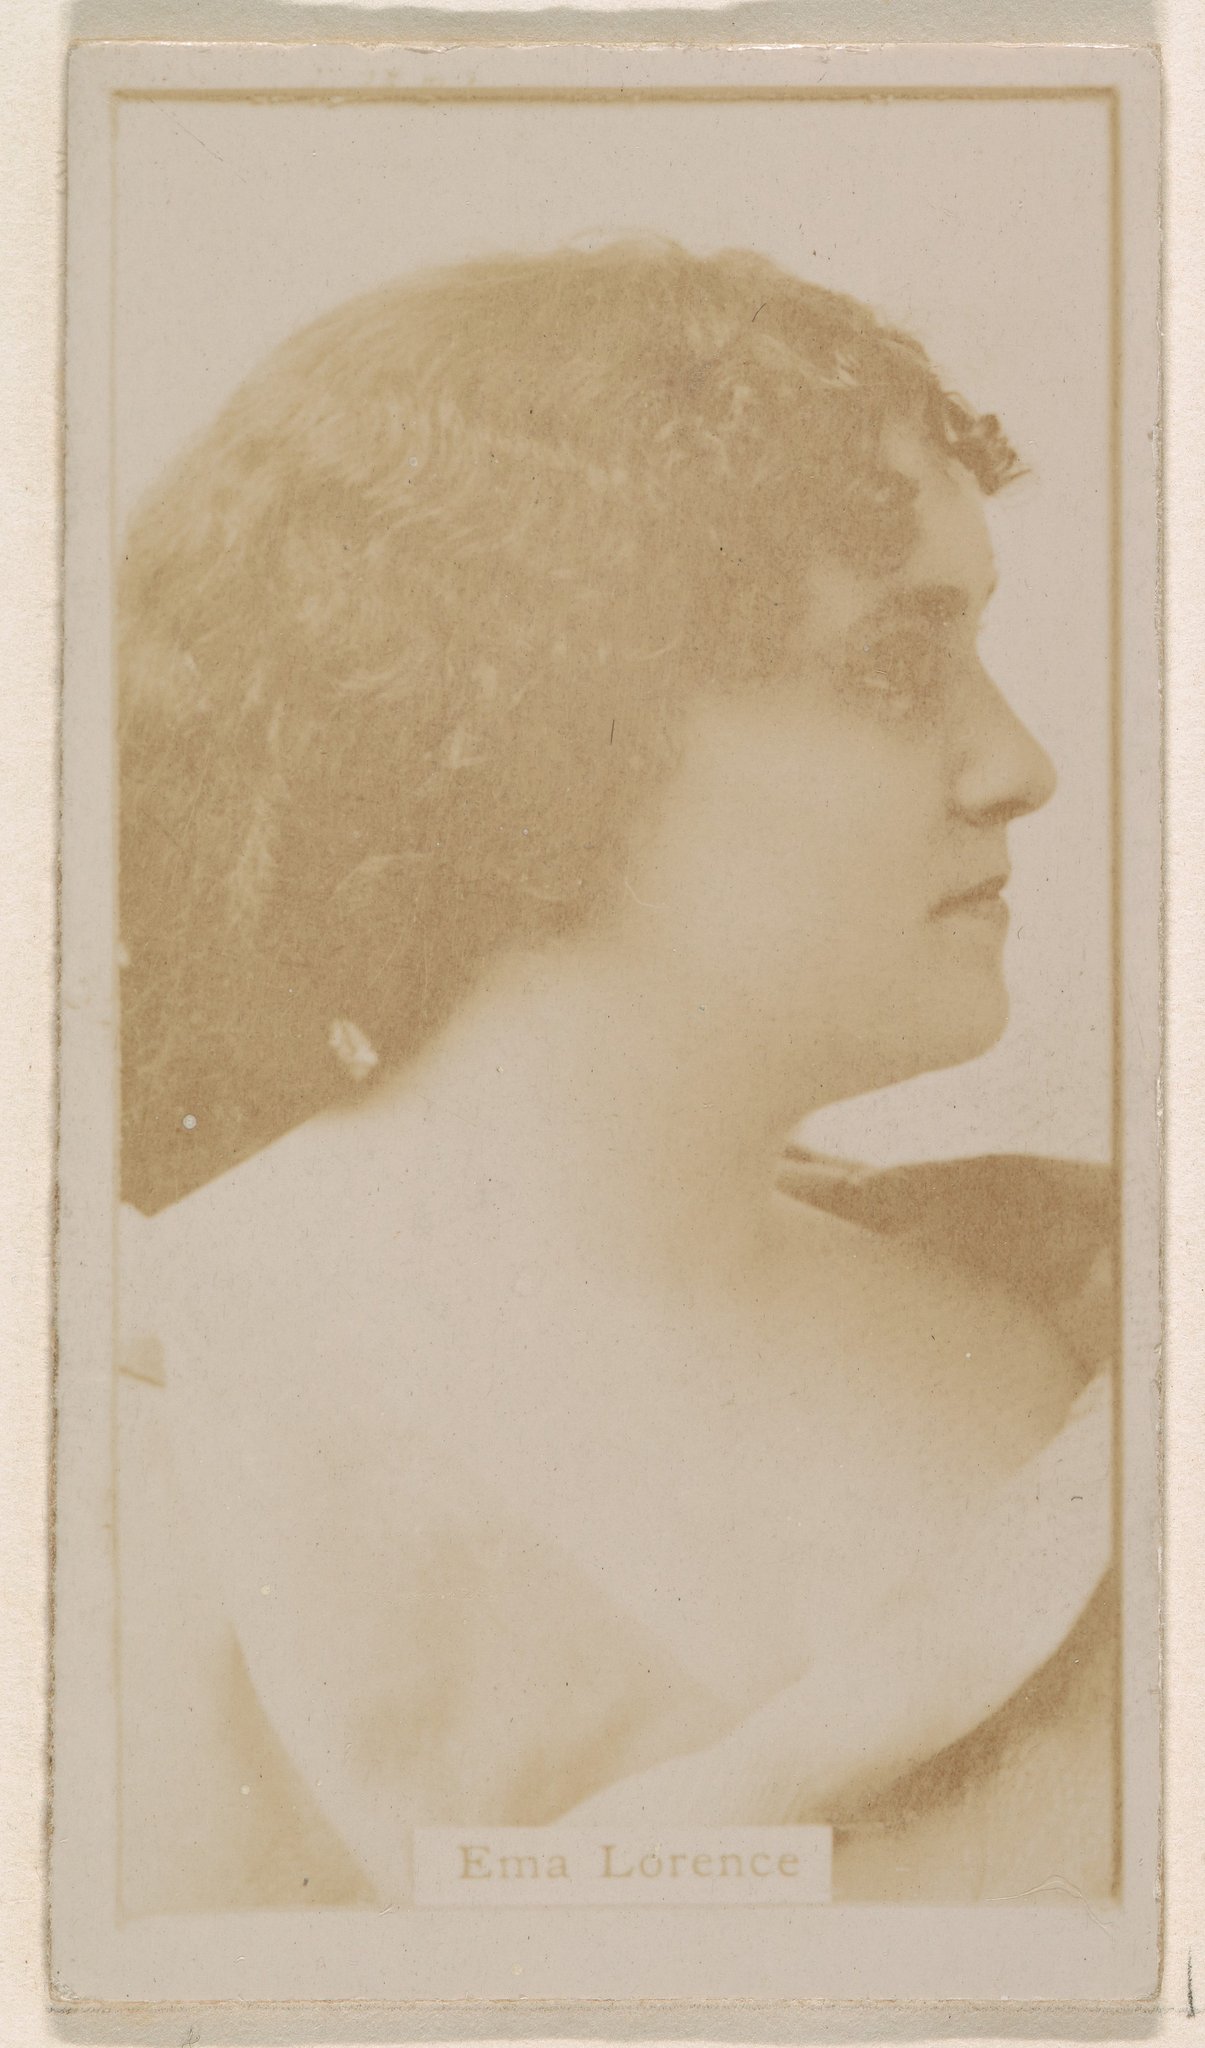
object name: photograph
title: Ema Lorence, from the Actresses series (N245) issued by Kinney Brothers to promote Sweet Caporal Cigarettes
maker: kinney brothers tobacco company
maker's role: publisher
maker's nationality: american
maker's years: 1869-2011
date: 1890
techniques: albumen silver print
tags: women,actresses